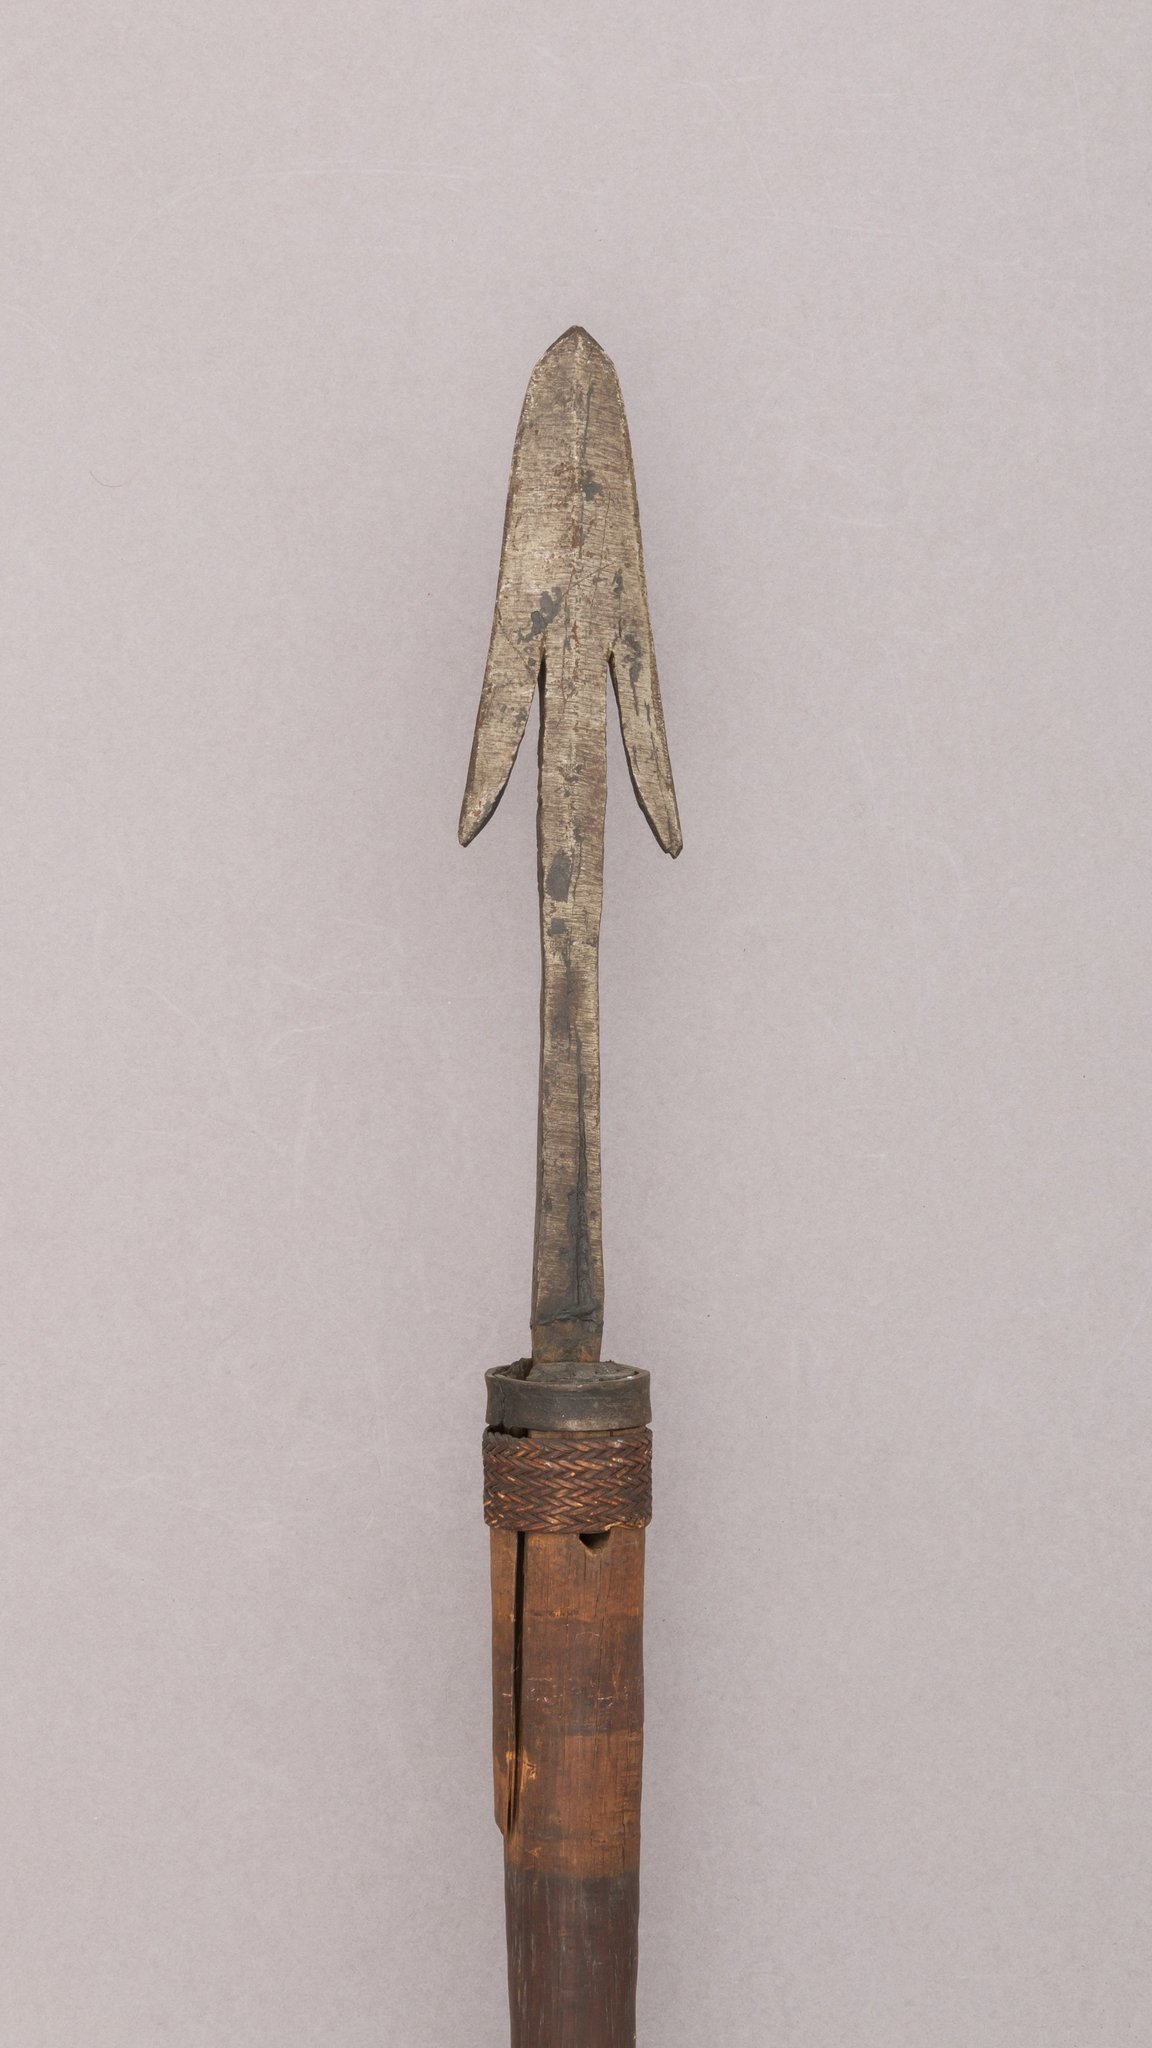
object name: spear falfeg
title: Spear (Falfeg)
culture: philippine or igorot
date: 1701-1900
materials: iron, steel, wood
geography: philippines